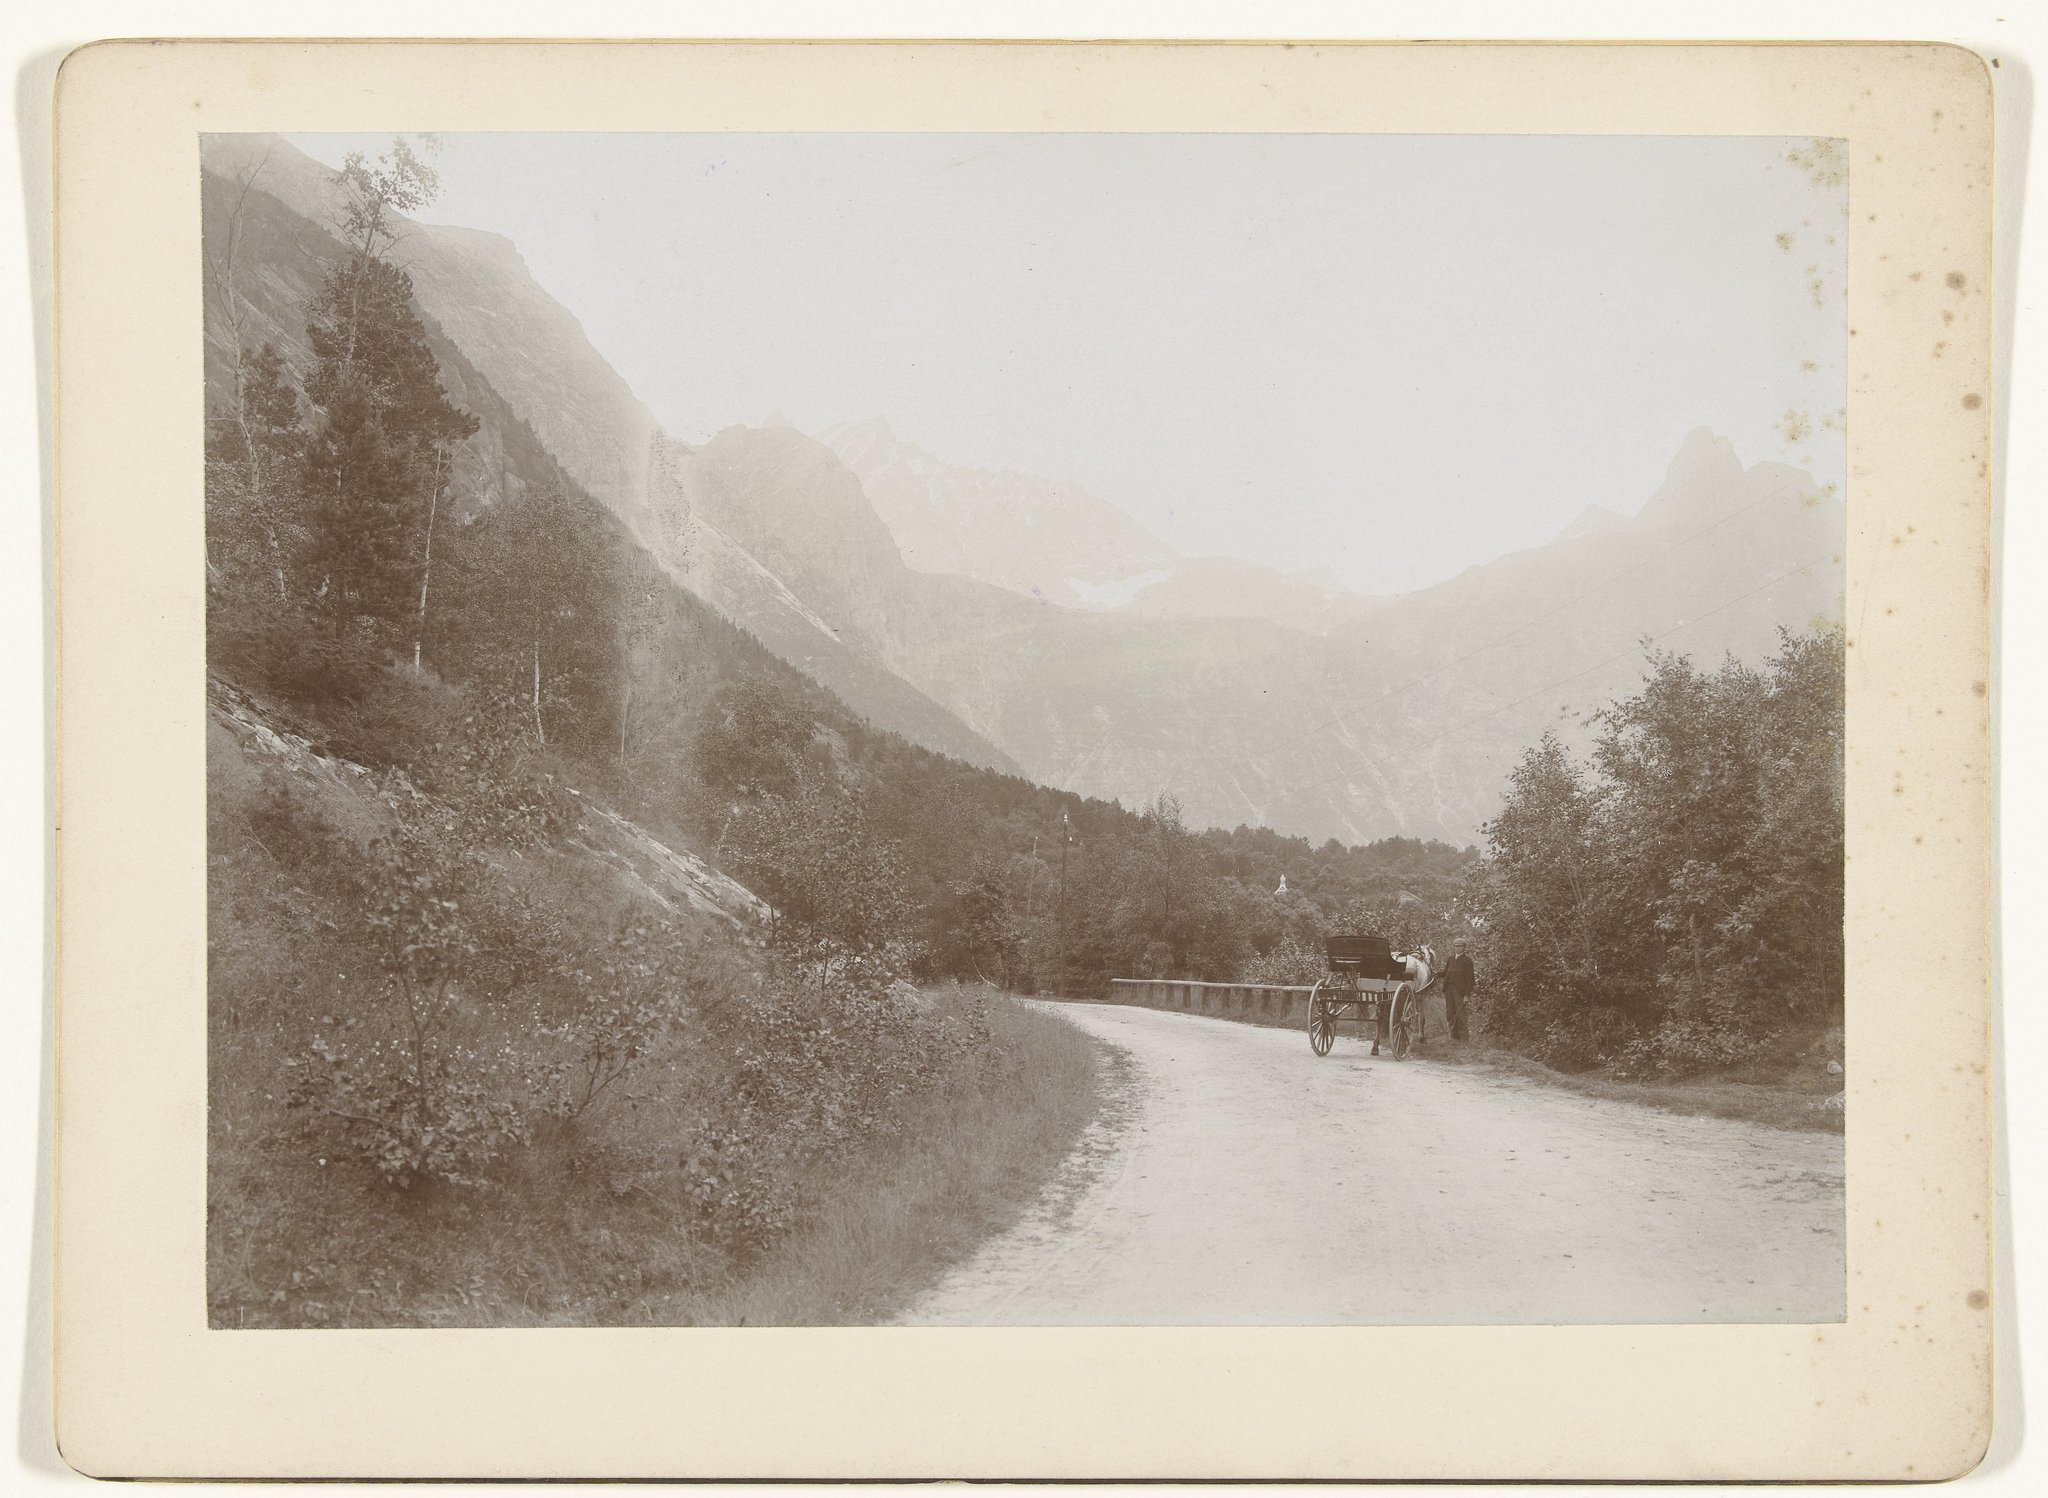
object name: photograph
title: Koets op een weg in een berglandschap (Noorwegen, Italië of Frankrijk)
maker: henry pauw van wieldrecht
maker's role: fotograaf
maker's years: 1863-1912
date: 1896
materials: cardboard, photographic support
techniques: gelatin silver print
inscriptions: annotation: ‘No. 1196. 1896.’